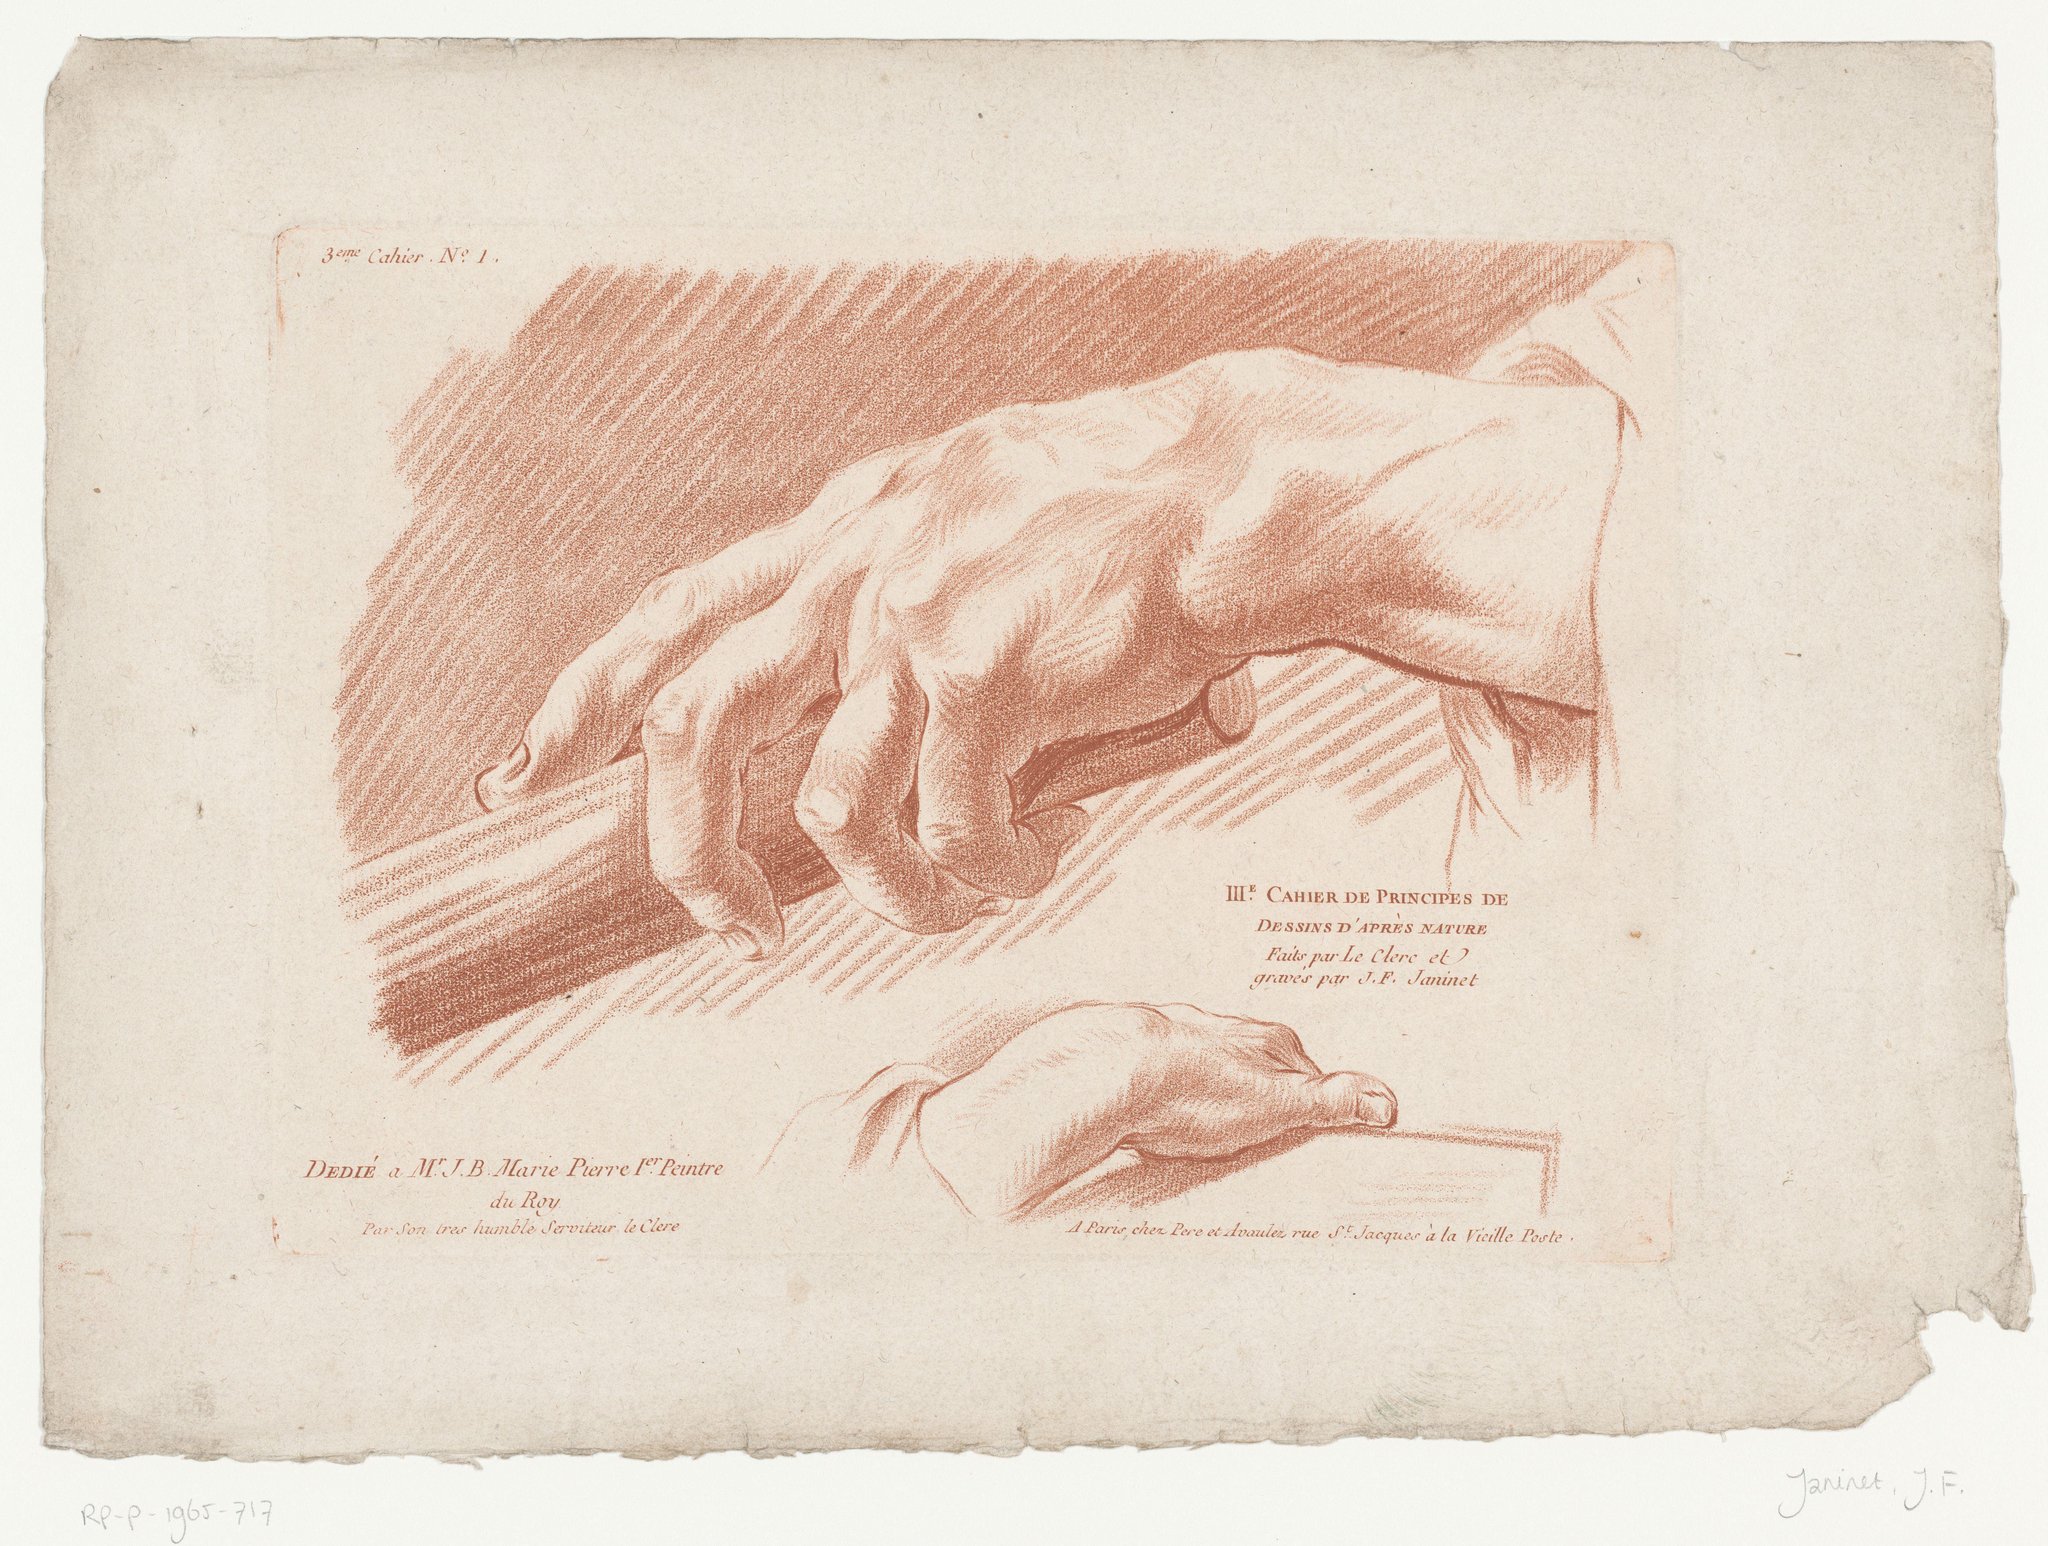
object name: print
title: III.e Cahier de Principes de Dessins d'après nature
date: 1773-1777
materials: paper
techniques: printmaking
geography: france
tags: hand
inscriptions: collector's mark: Lugt 2228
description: Deze prent maakt deel uit van een album dat uit minstens elf delen bestaat. Dit is het eerste blad van het derde album. Waarschijnlijk dienden deze albums als voorbeeld voor tekenaars, schilders en graveurs.